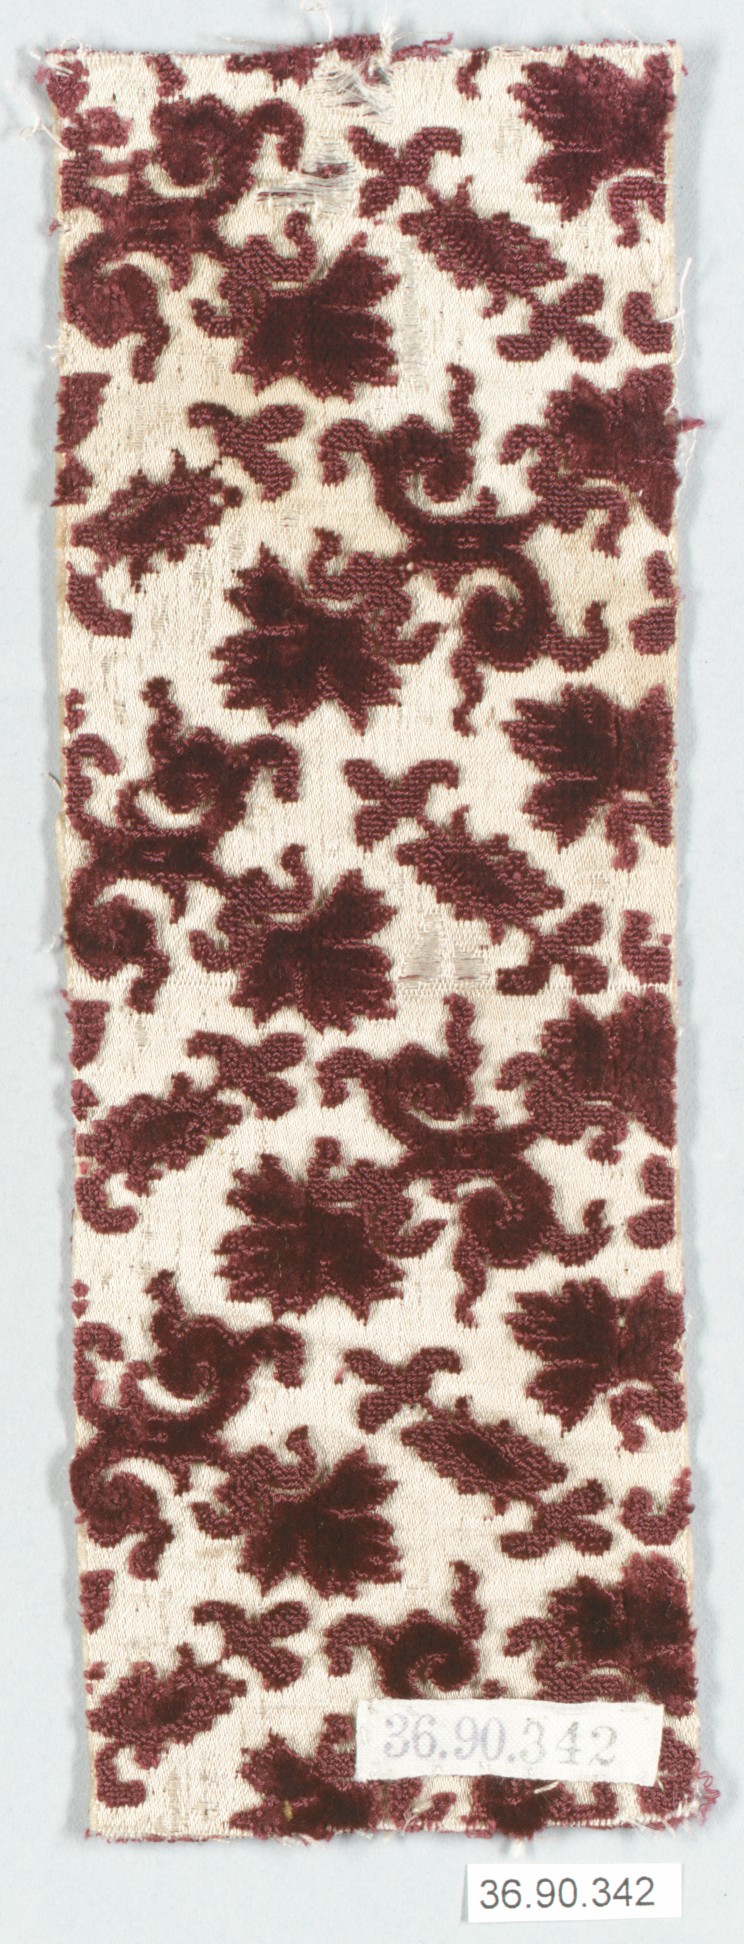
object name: piece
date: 1501-1700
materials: silk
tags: leaves